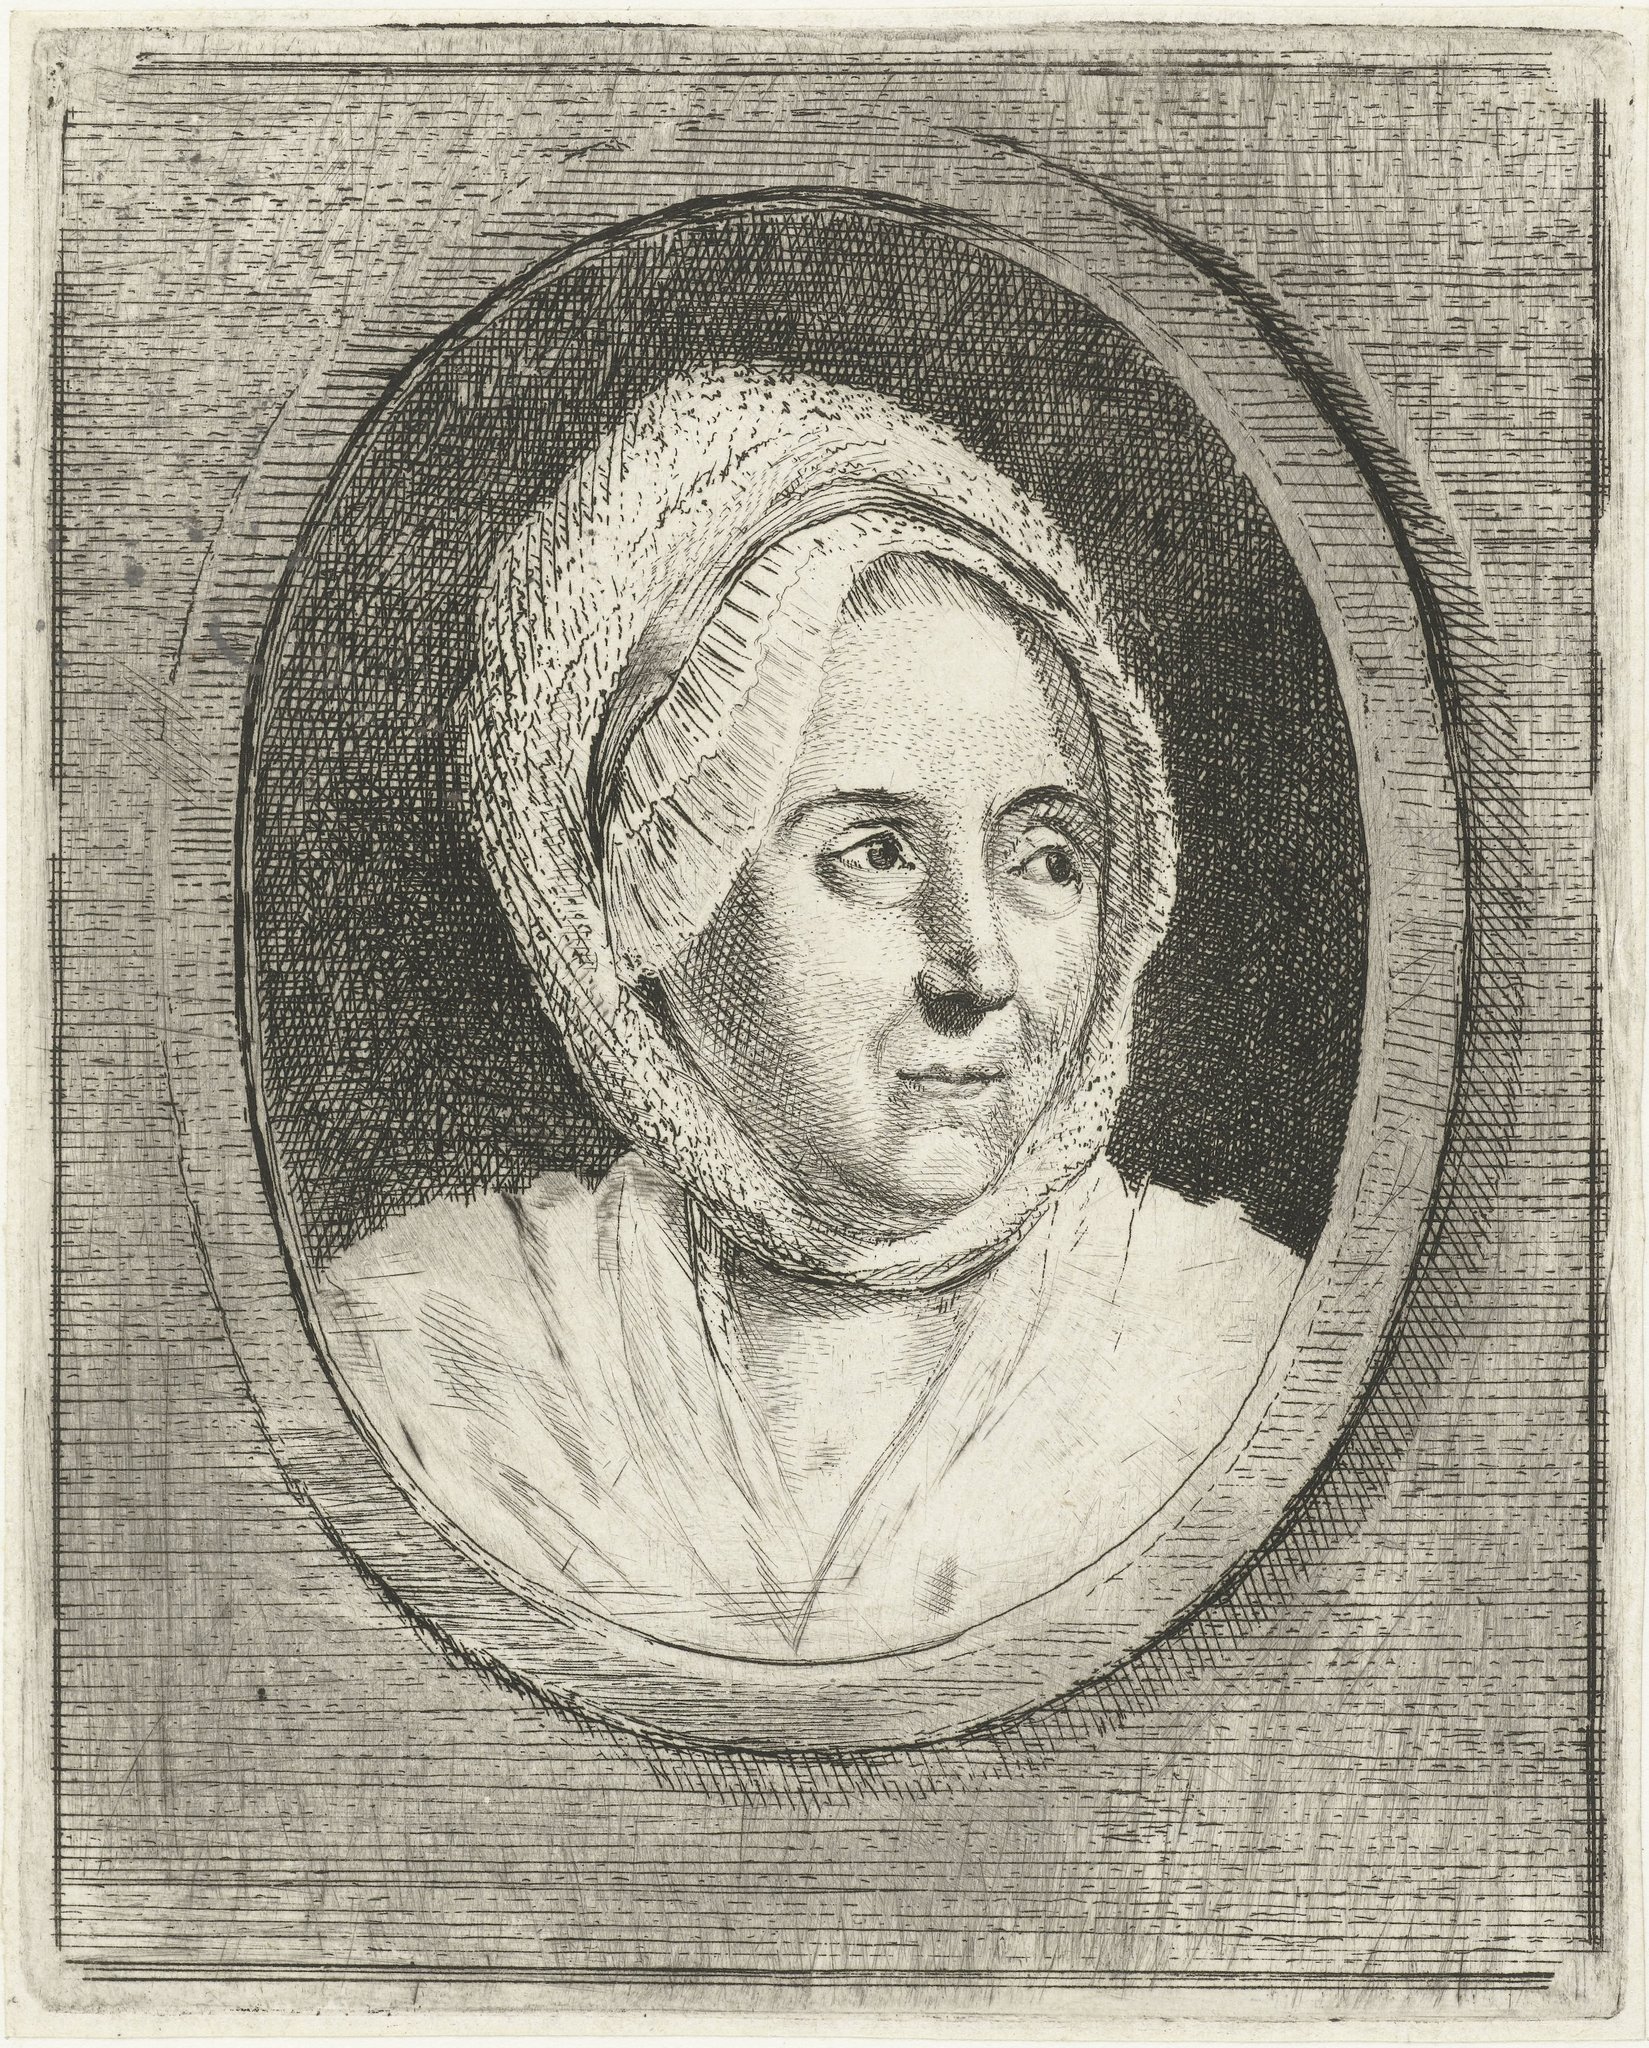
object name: print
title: Portret van een vrouw met kapje (Marie Joseph Bertrand?)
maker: louis bernard coclers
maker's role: draughtsman, print maker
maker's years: 1741-1817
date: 1756-1817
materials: paper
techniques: drypoint, etching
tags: anonymous historical person portrayed alone - bb - woman, head-gear: cap (+ women's clothes)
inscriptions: collector's mark: Lugt 2228